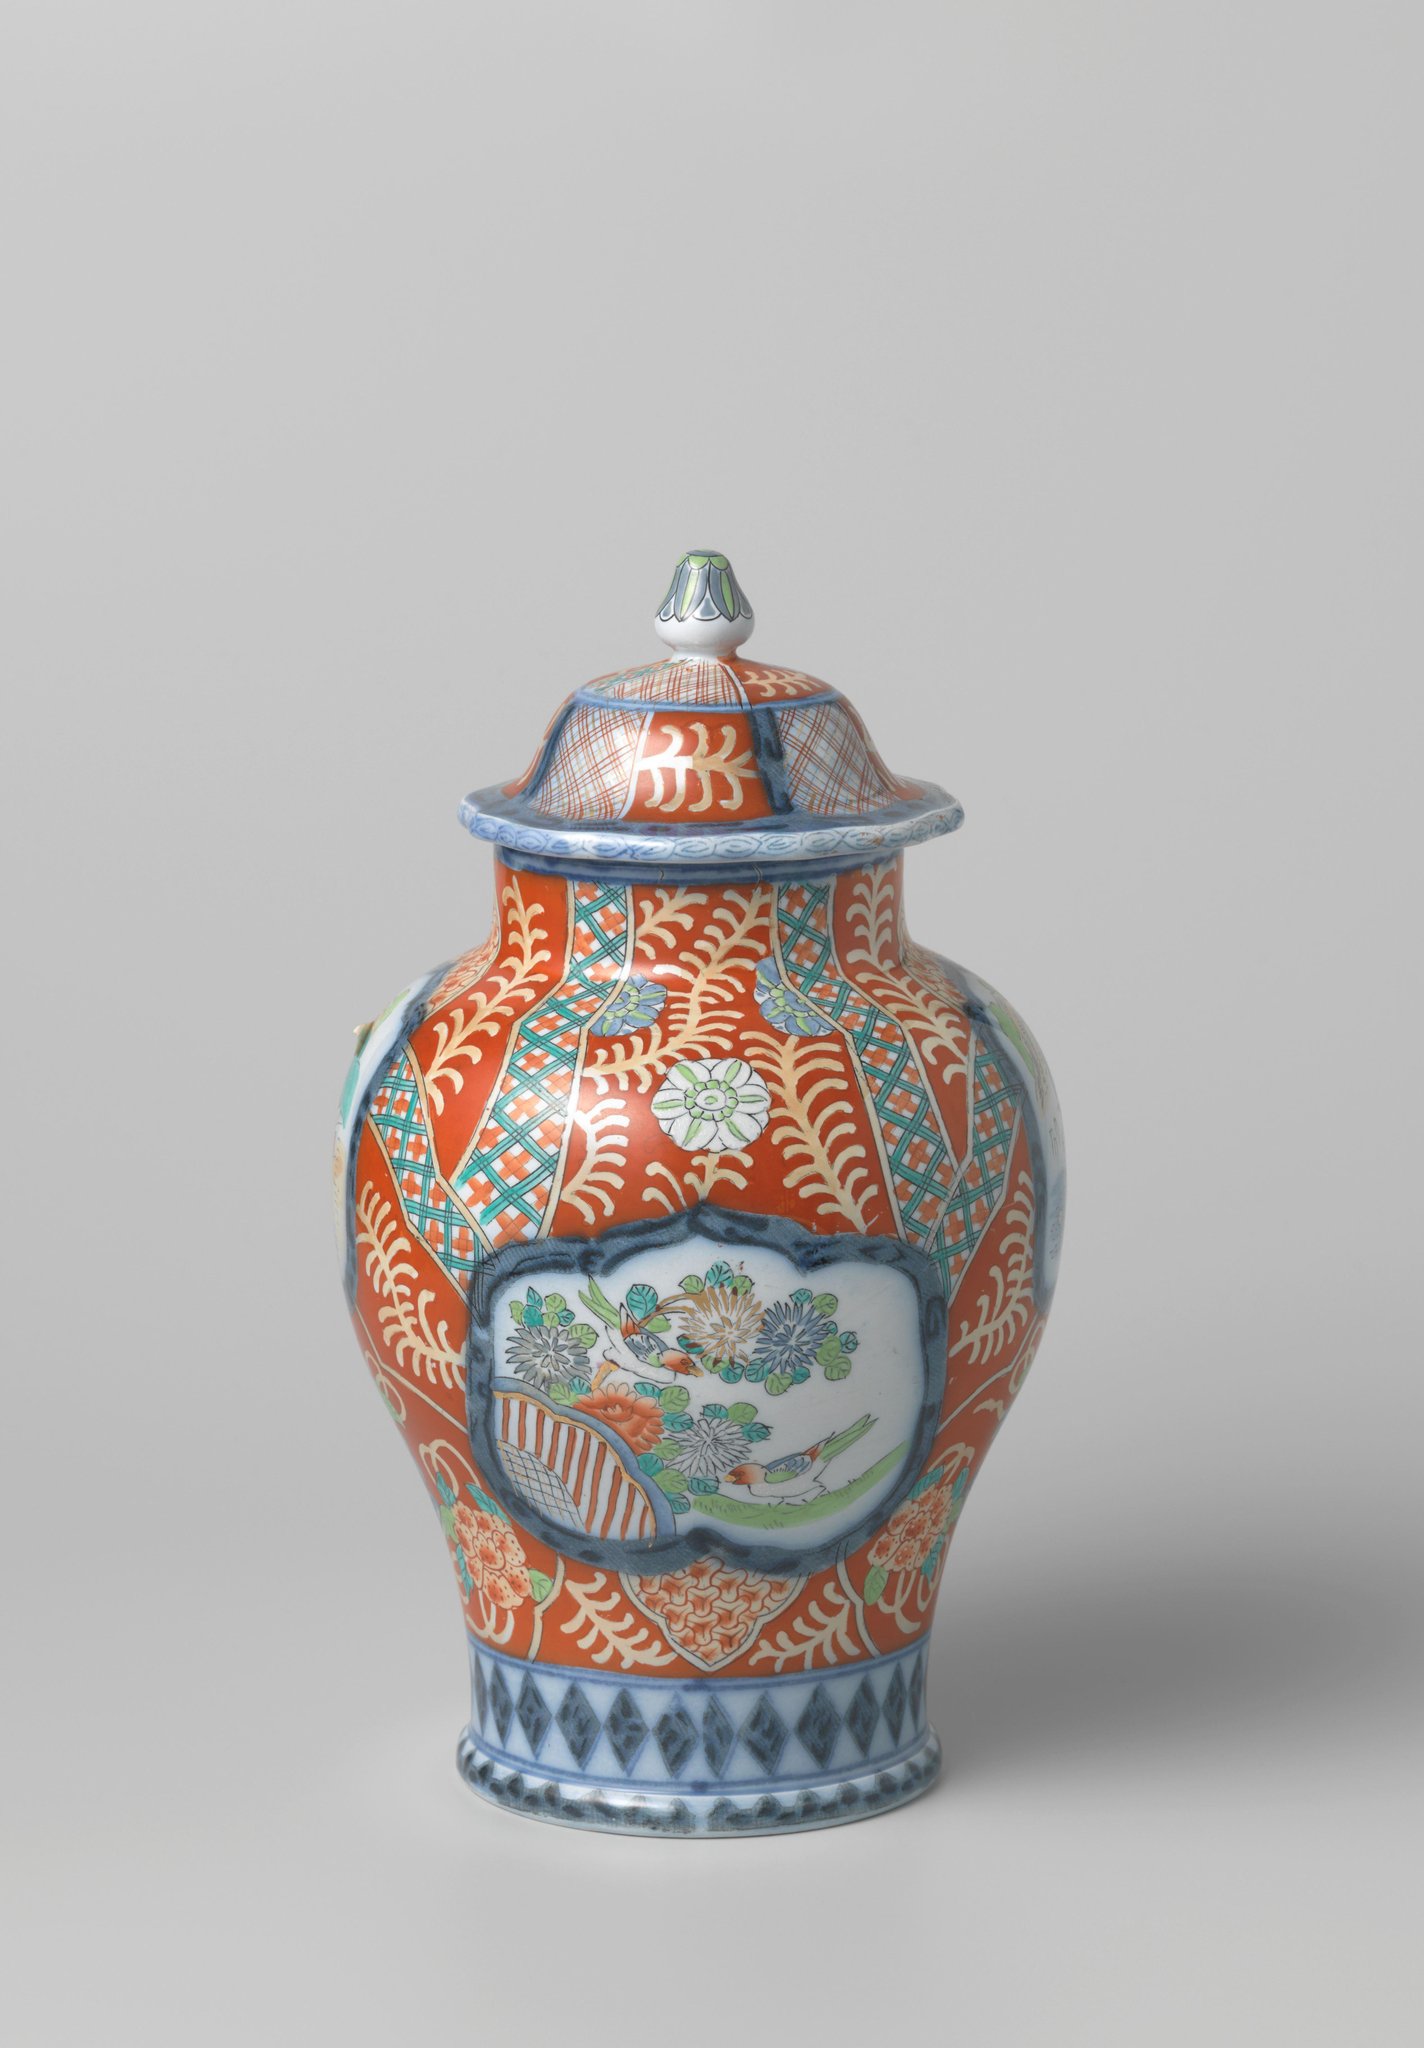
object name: covered jar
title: Dekselpot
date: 1886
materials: earthenware, glaze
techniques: vitrification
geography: maastricht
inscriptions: mark: ‘Sfinx // P. REGOUT & Co // MAASTRICHT’, check stamp: ‘3’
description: Dekselpot van aardewerk, behorend bij een driedelig kaststel, met zwarte en vloeiblauwe transferdecoratie, beschilderd met emailkleuren en okerluster, met goud gehoogd. Op de buik twee cartouches met vogels en takken, en twee cartouches met een landschap.